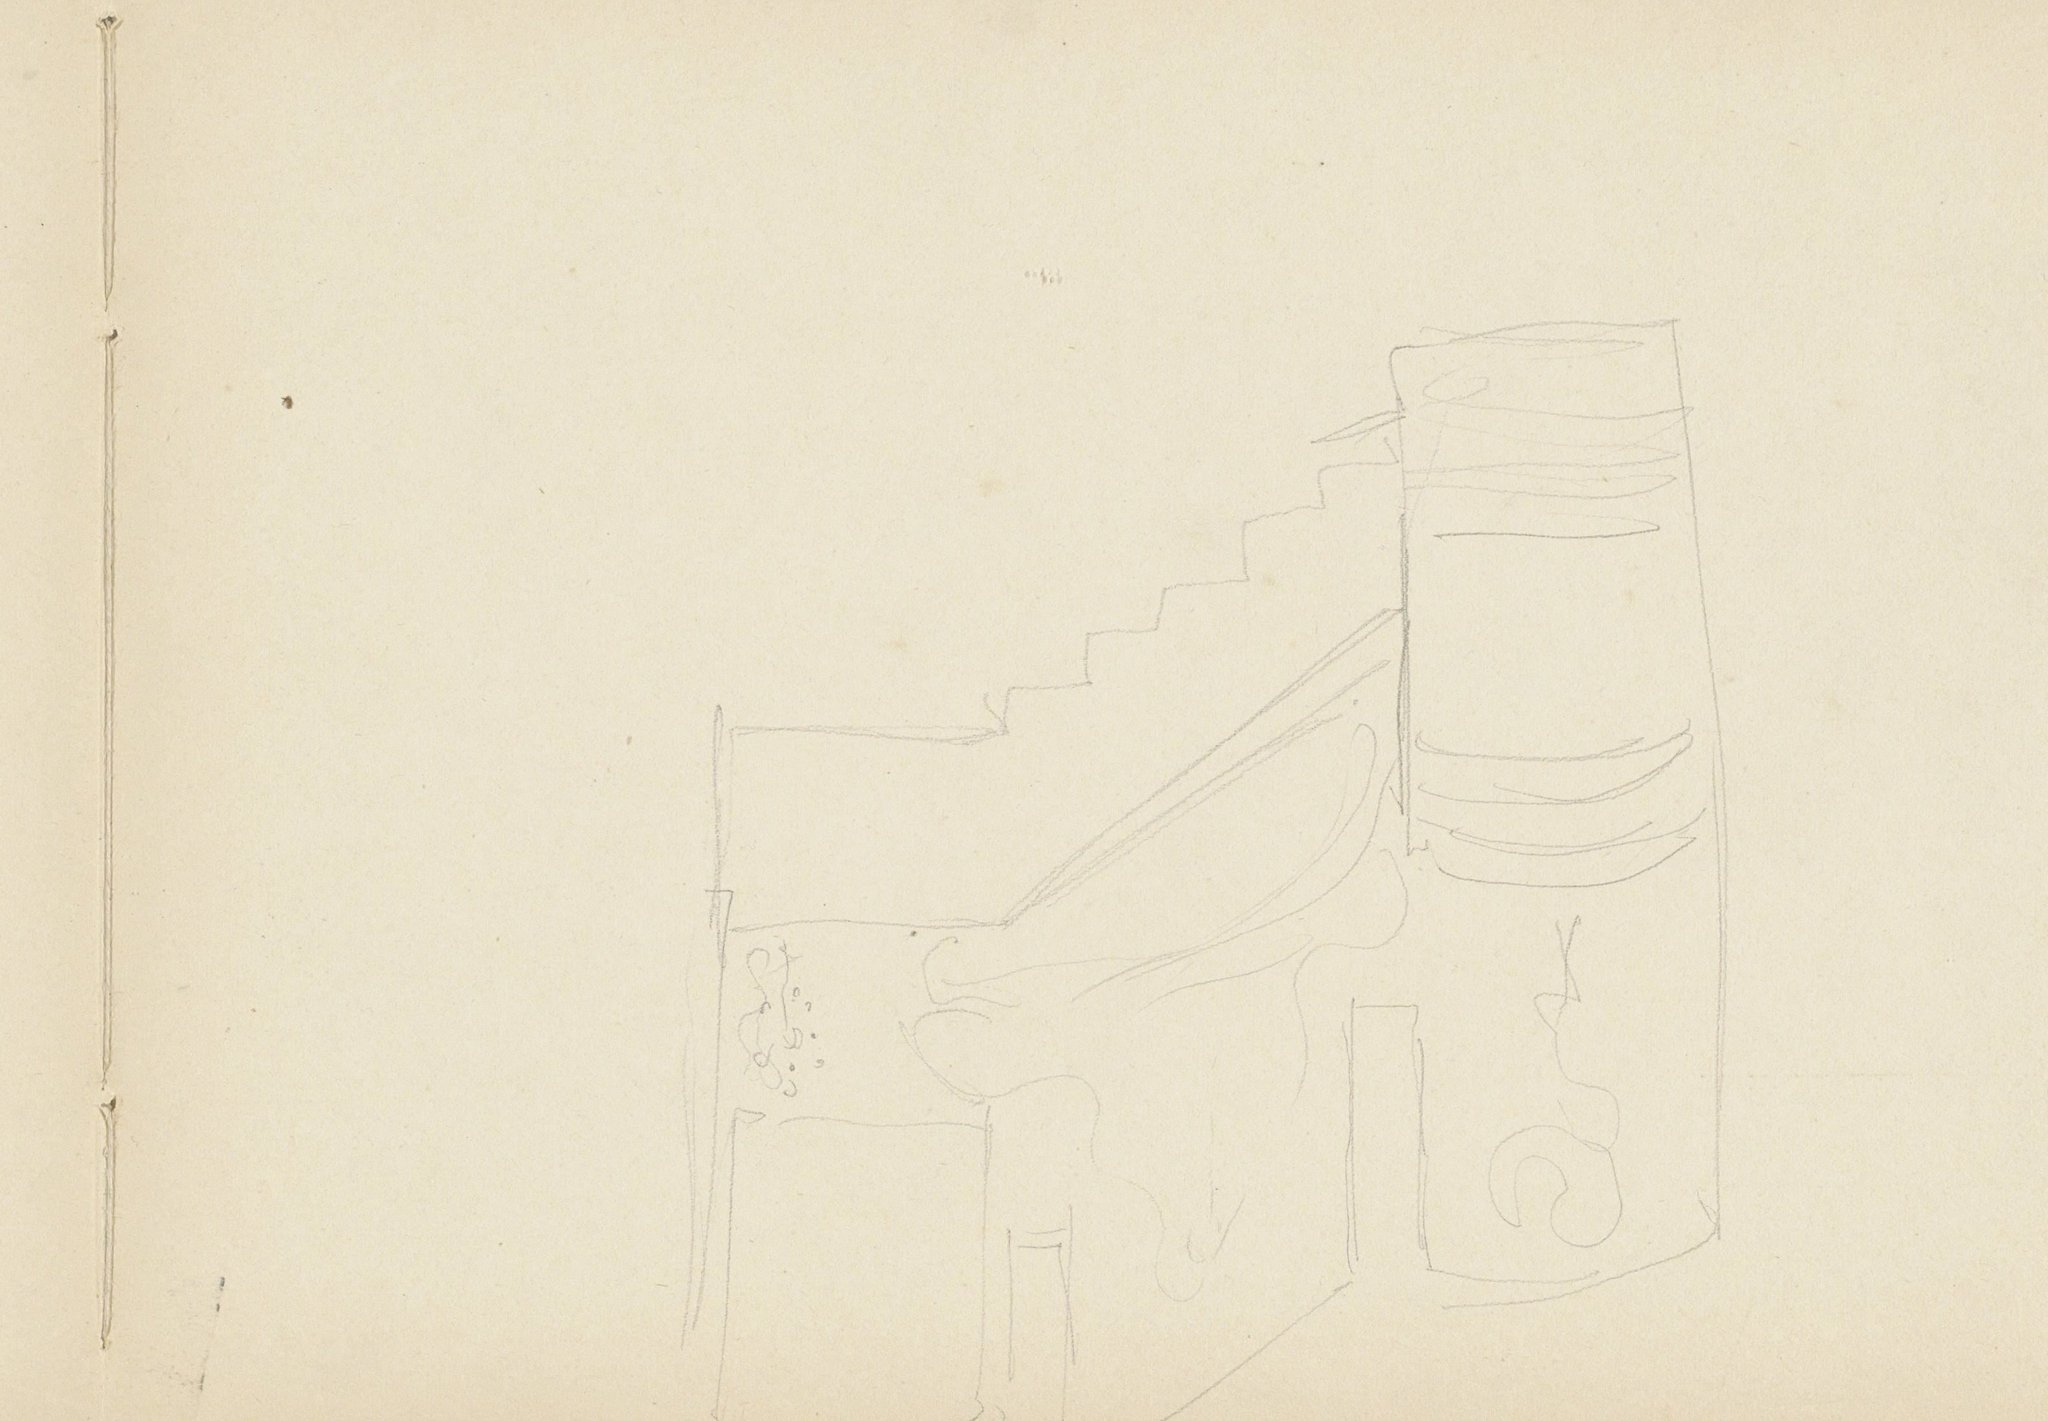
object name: sketchbook leaf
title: Studie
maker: antoon derkinderen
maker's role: draughtsman, painter, print maker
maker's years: 1859-1925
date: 1869-1925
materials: paper, pencil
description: Mogelijk (fantasie)architectuur. Blad 11 recto uit een schetsboek met 28 bladen.